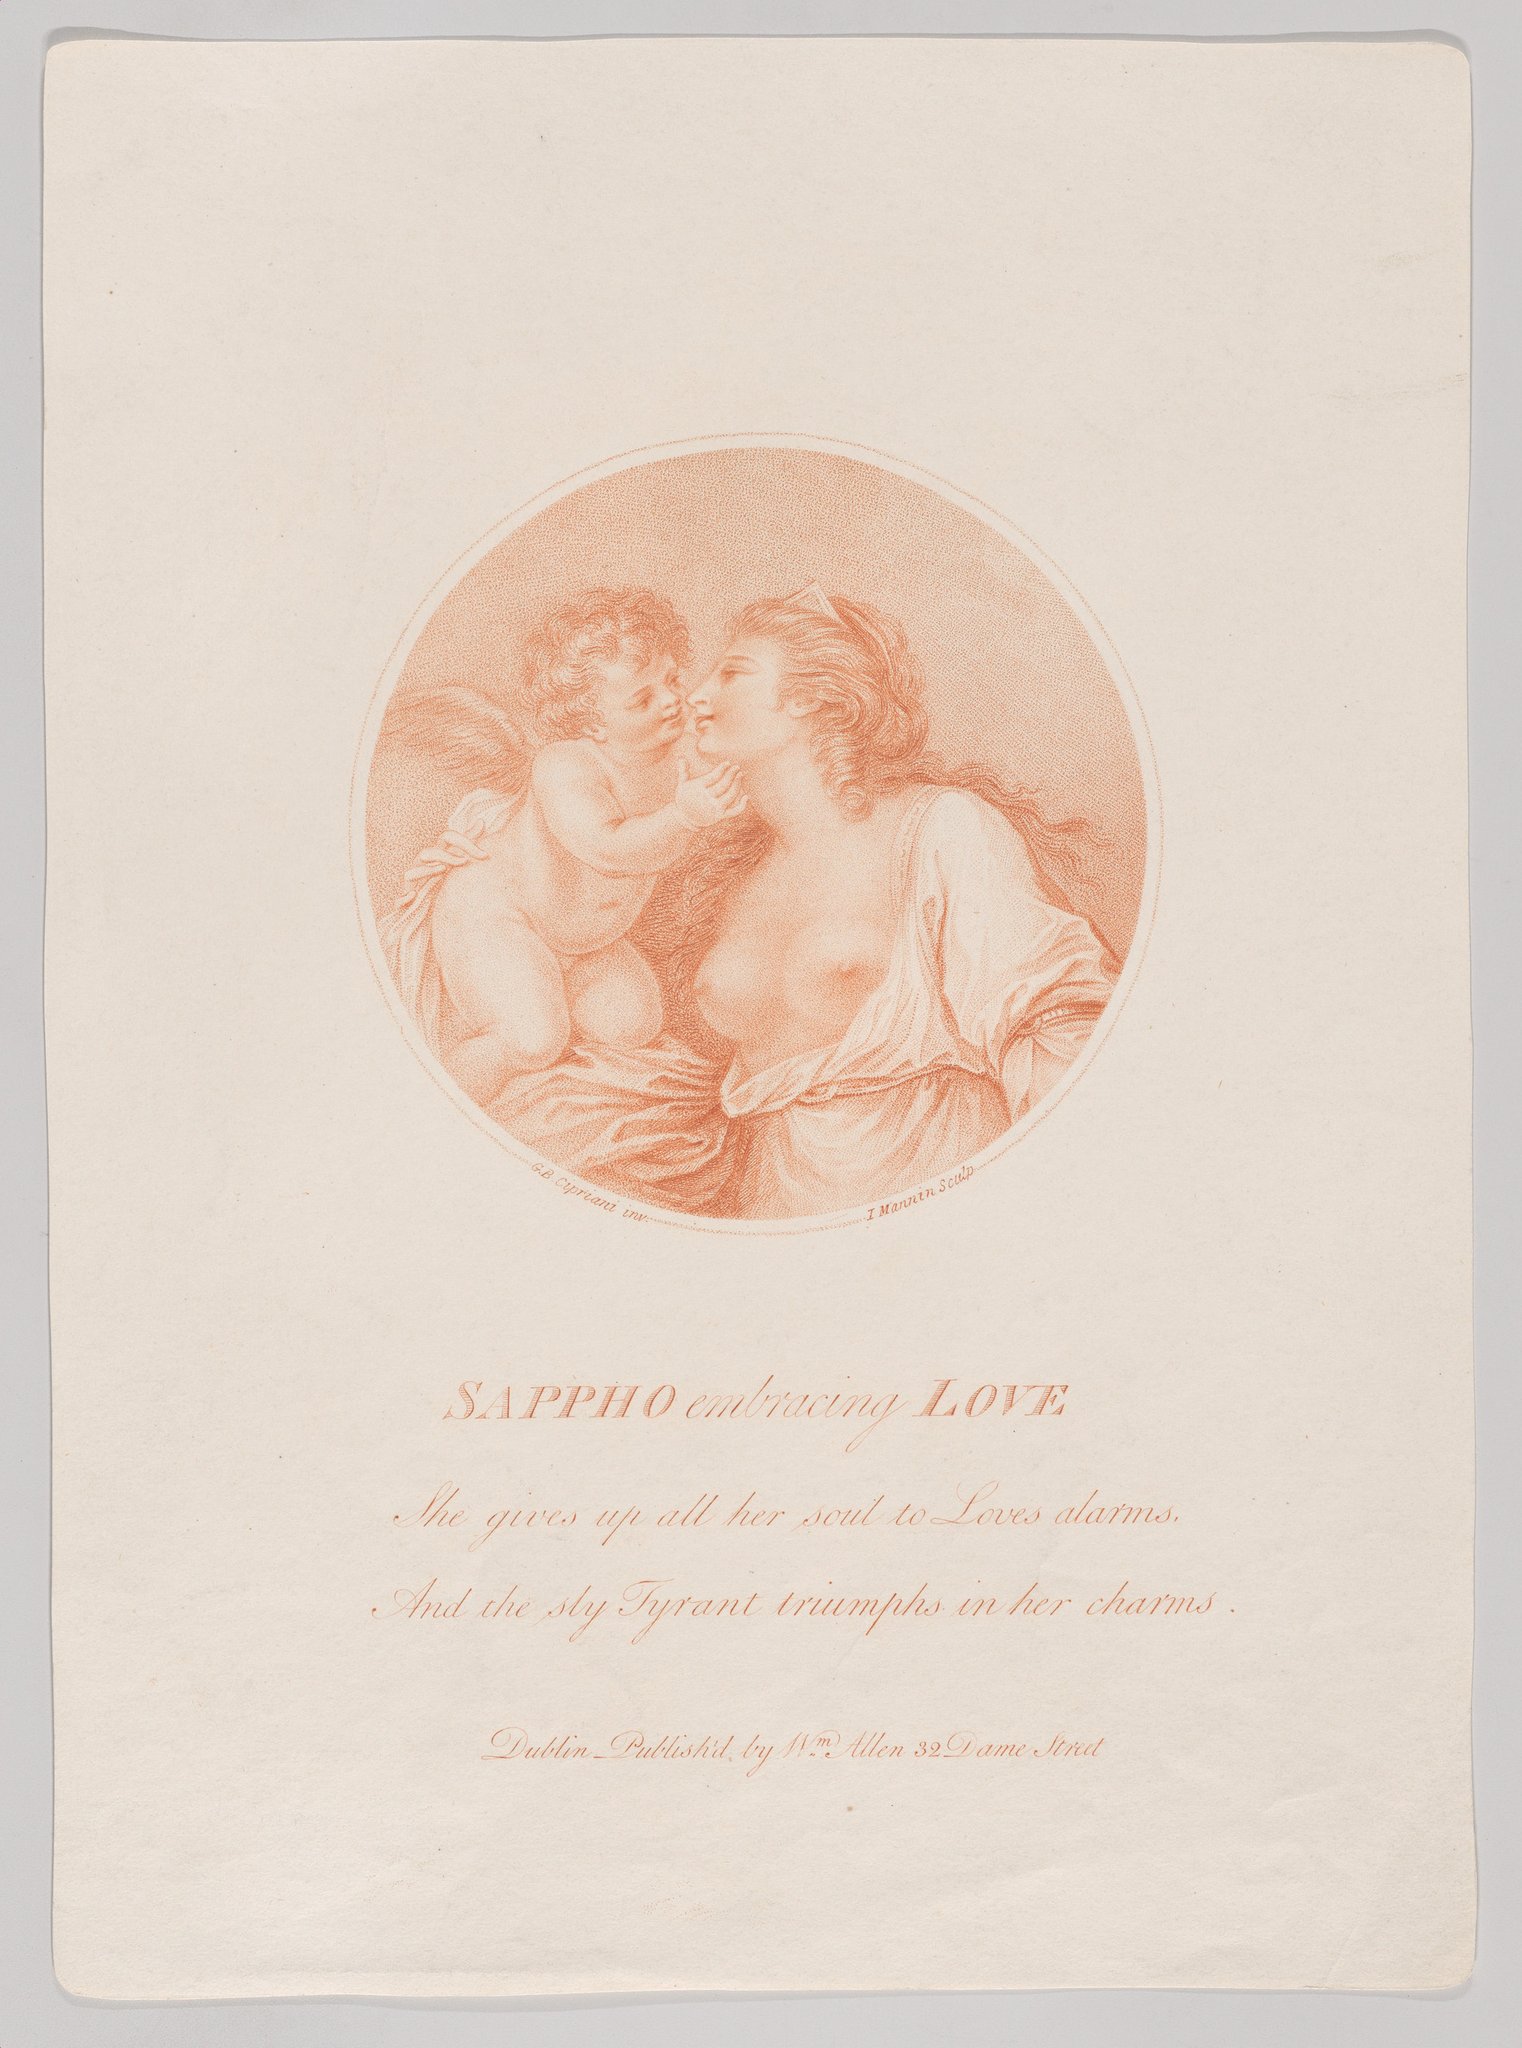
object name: print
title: Sappho embracing Love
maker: john mannin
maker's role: artist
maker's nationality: irish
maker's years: 1691-1791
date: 1786-1791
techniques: etching, printing, engraving